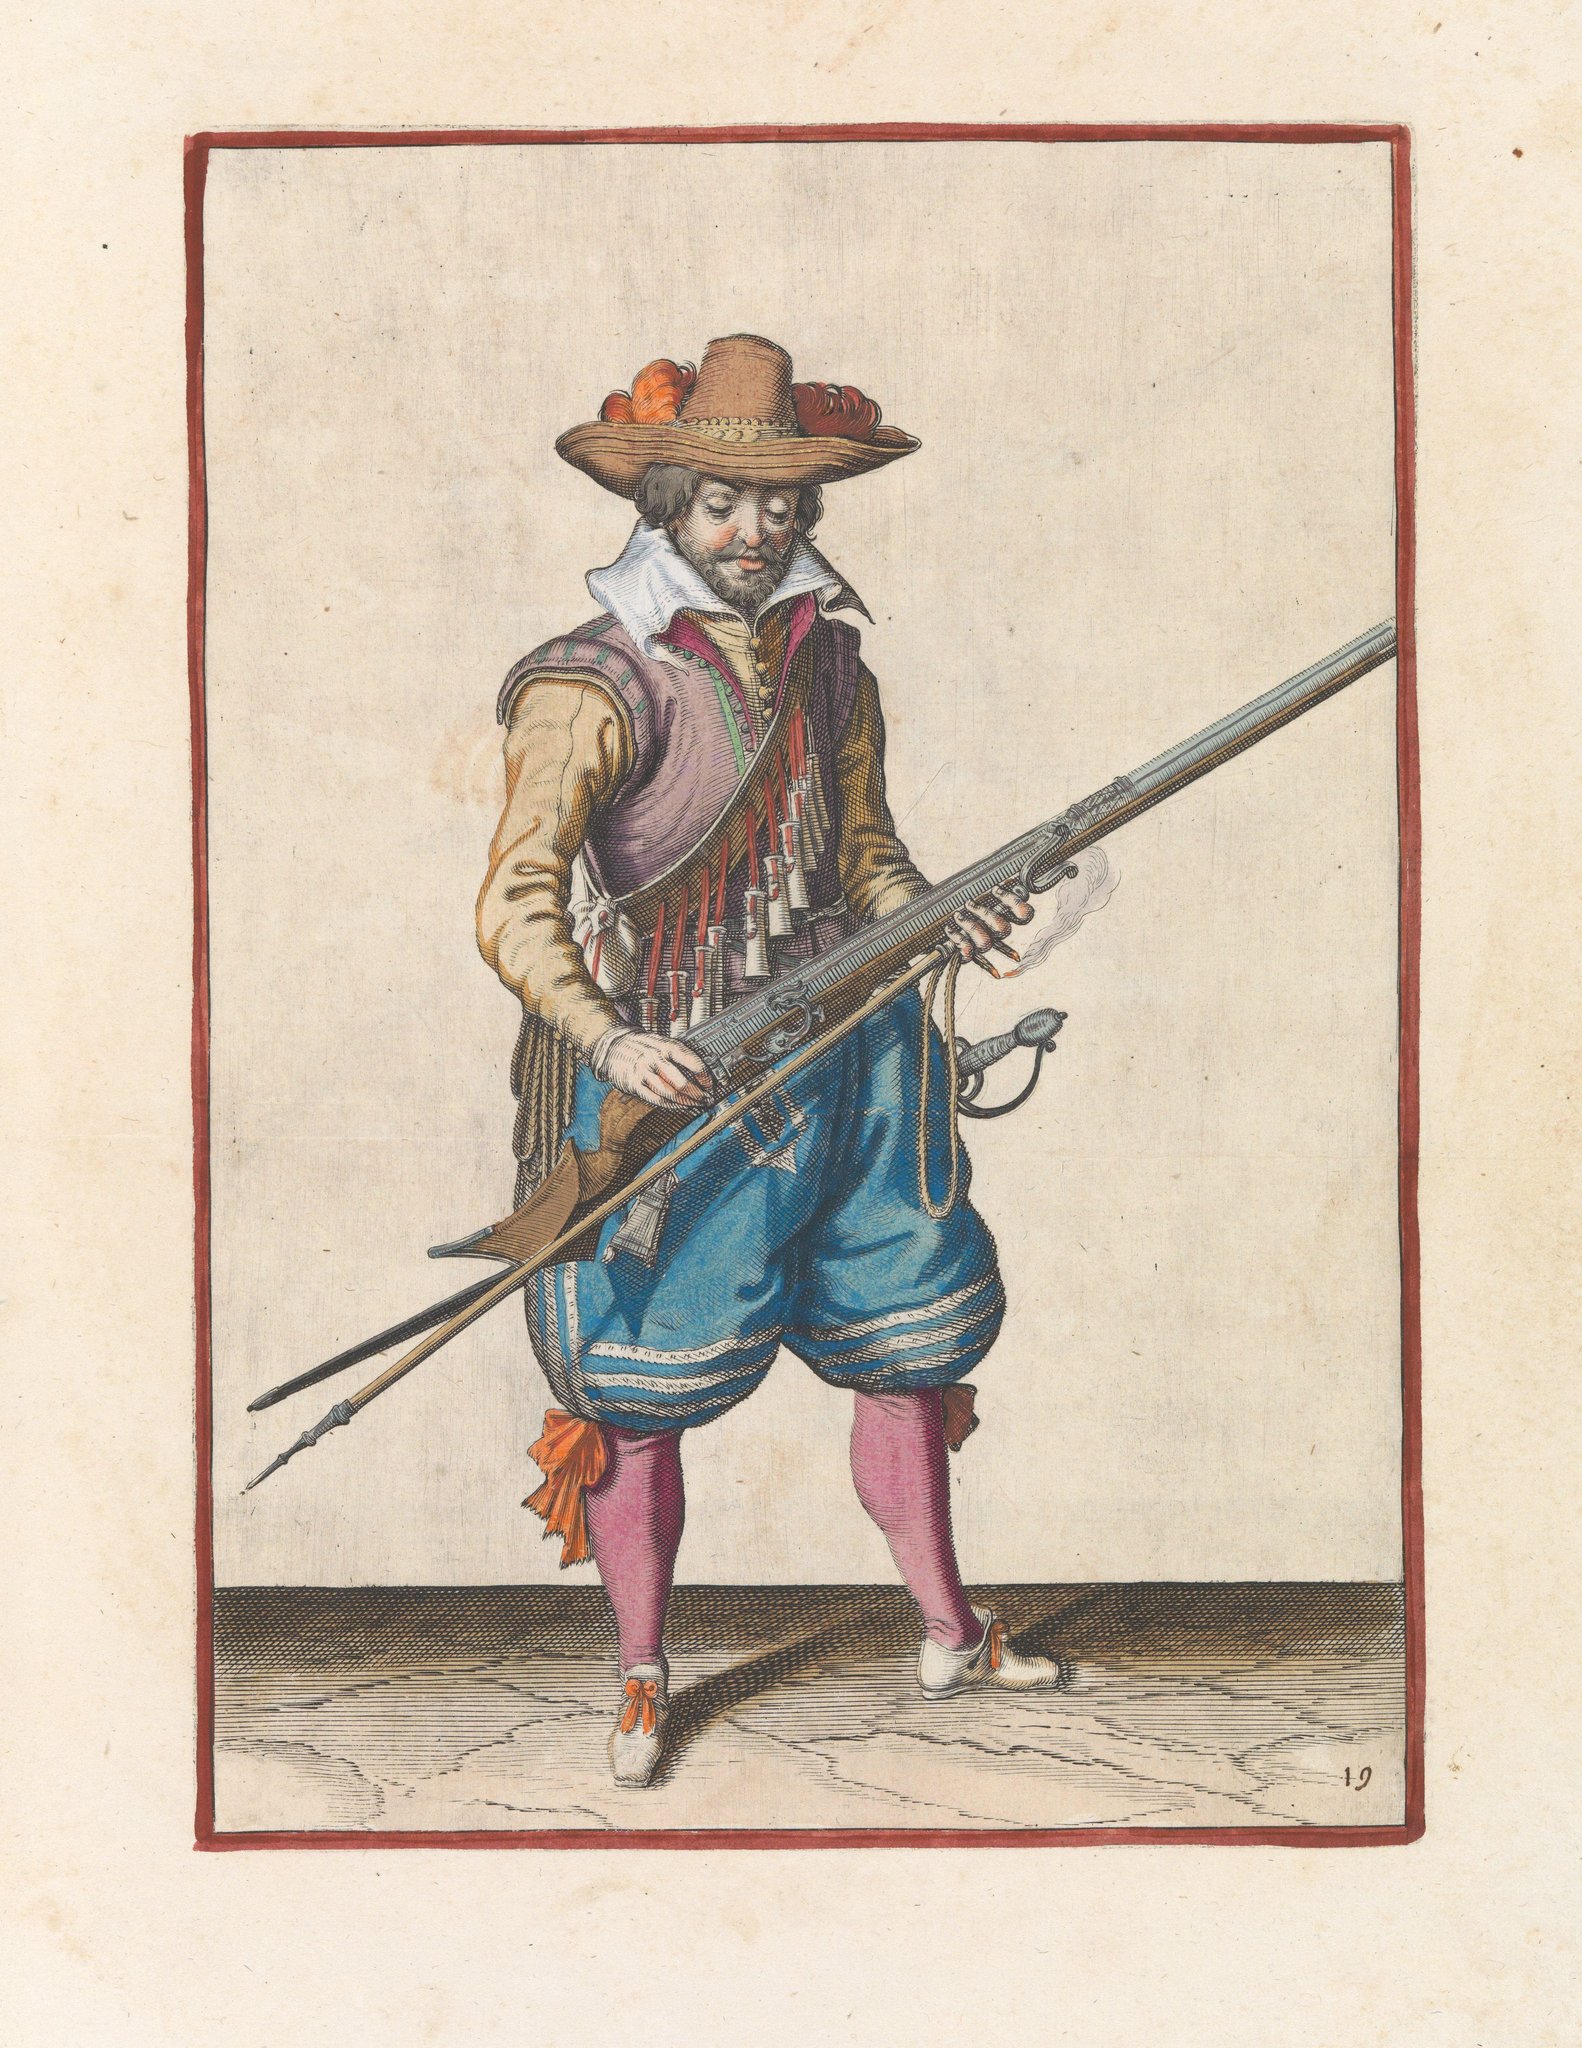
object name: print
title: Corte onderrechtinghe op de figuerliicke afbeeldinghe, soo veel aengaet het recht ghebruyck vant Musquet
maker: jacques de gheyn (ii)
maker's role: painter, print maker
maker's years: 1565-1629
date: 1597-1607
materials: paper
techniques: engraving, hand coloring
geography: the hague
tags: handling of weapons ~ military training, firearms: rifle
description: Een soldaat, ten voeten uit, naar rechts, die met beide handen een musket (een bepaald type vuurwapen) schudt, om eventueel buiten de pan (het kruitreservoir) gevallen kruit ervan af te krijgen. In zijn linkerhand behalve de loop van het musket ook een furket (musketvork) en een brandende lont. Deze prent is onderdeel van de reeks van 43 met de hand genummerde prenten van musketiers in de Wapenhandelinghe.